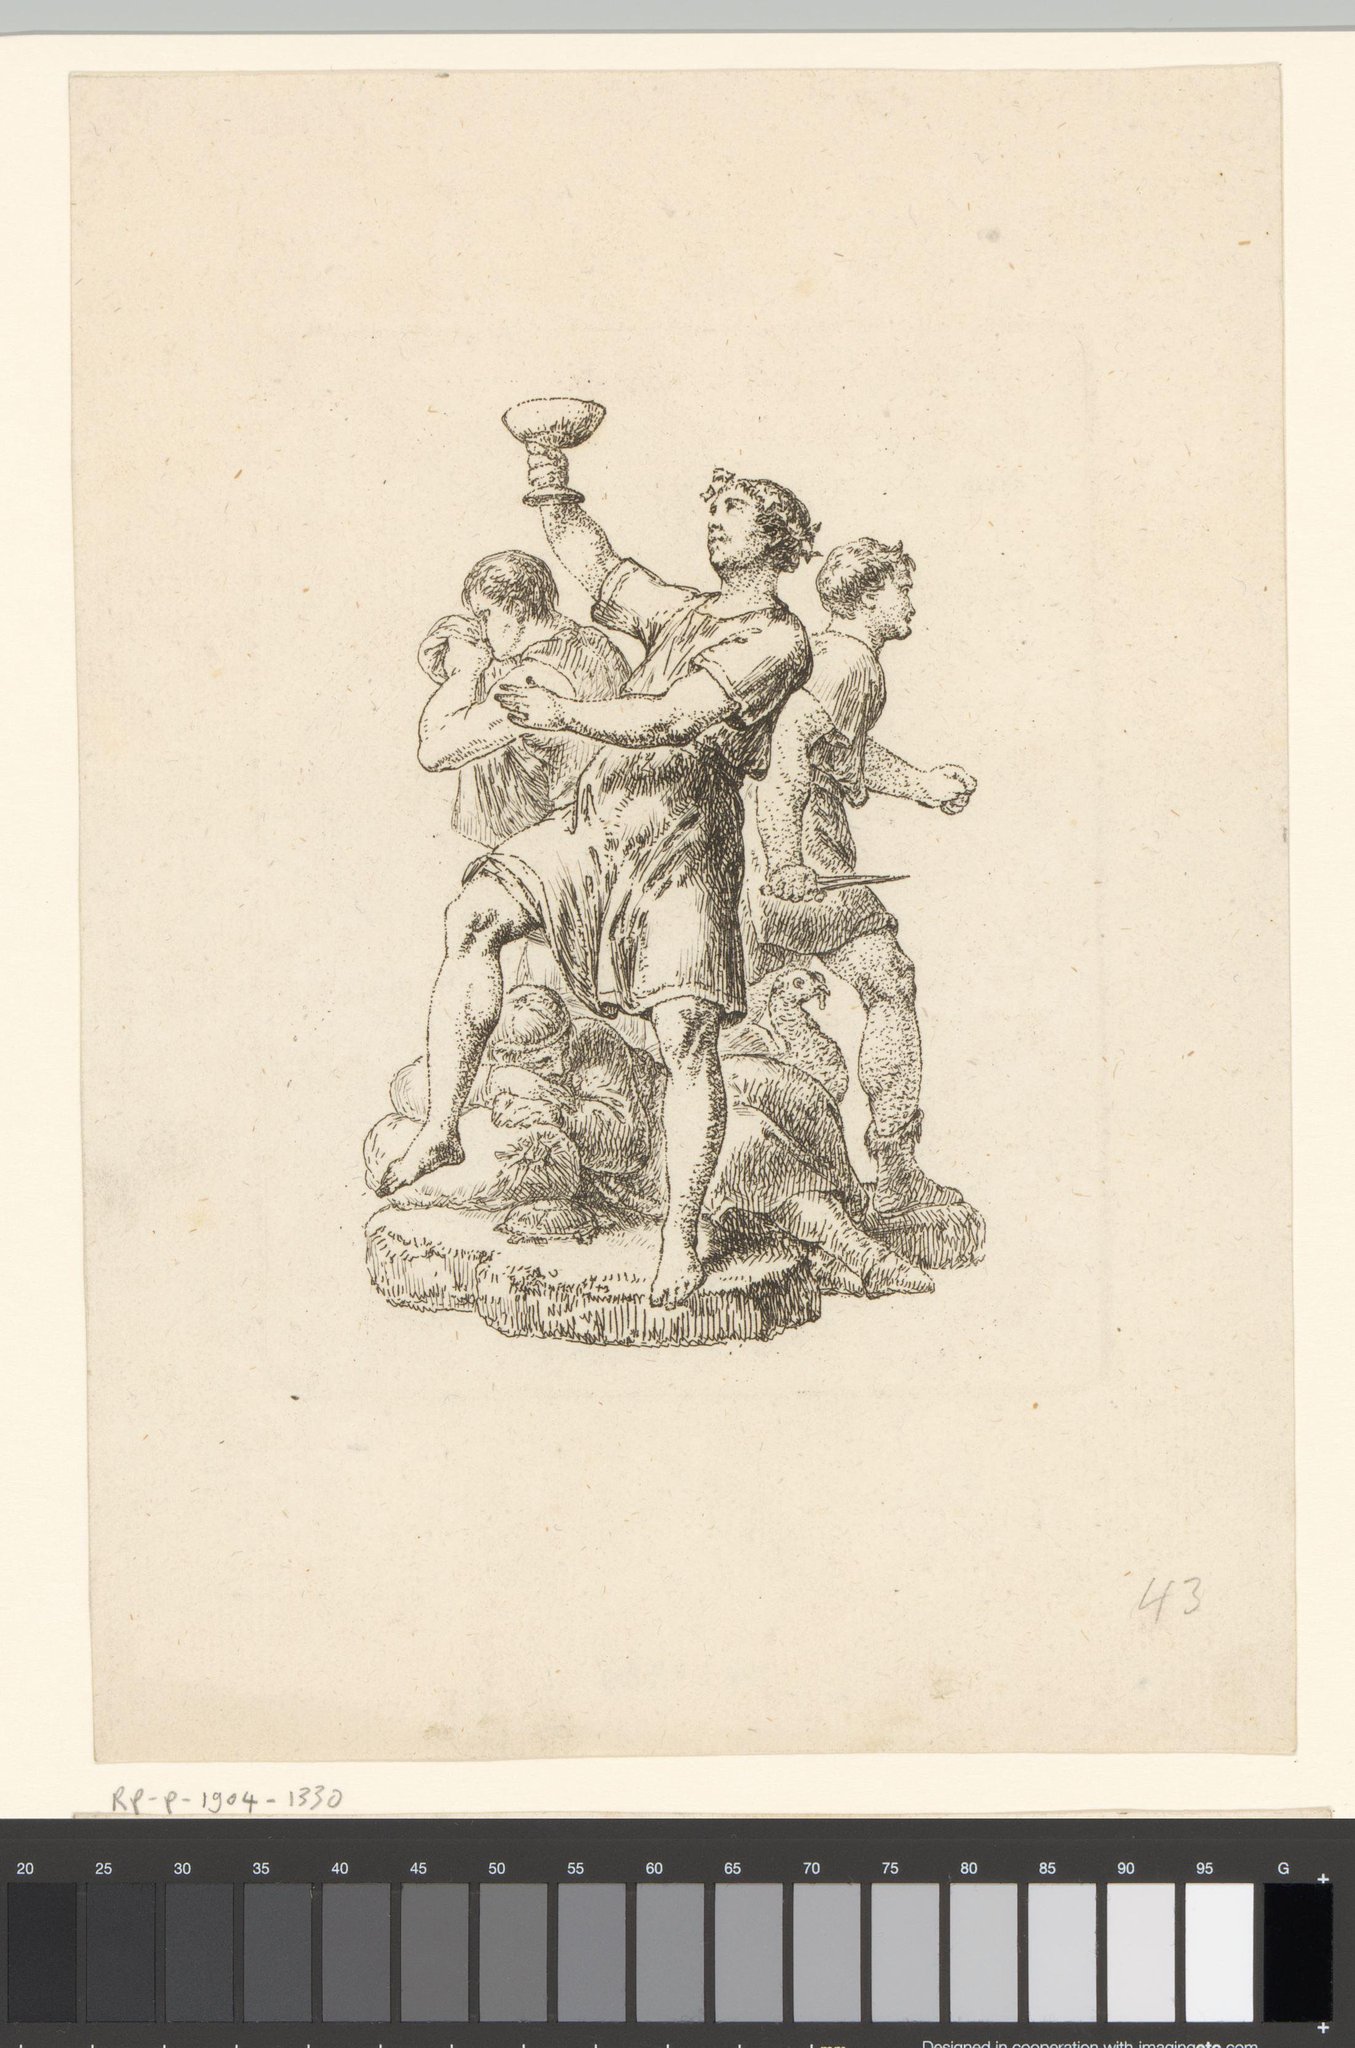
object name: print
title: Allegorie van de vier temperamenten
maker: bernhard rode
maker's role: artist, print maker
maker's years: 1725-1797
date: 1788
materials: paper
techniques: etching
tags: 32a1 the four temperaments; 'complessione' (ripa)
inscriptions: collector's mark: Lugt 2228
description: Prent ook gebruikt in: Ramler, Karl Wilhelm. Allegorische Personen zum Gebrauche der bildenden Künstler. Berlijn: Akademischen Kunst- und Buchhandlung, 1788.